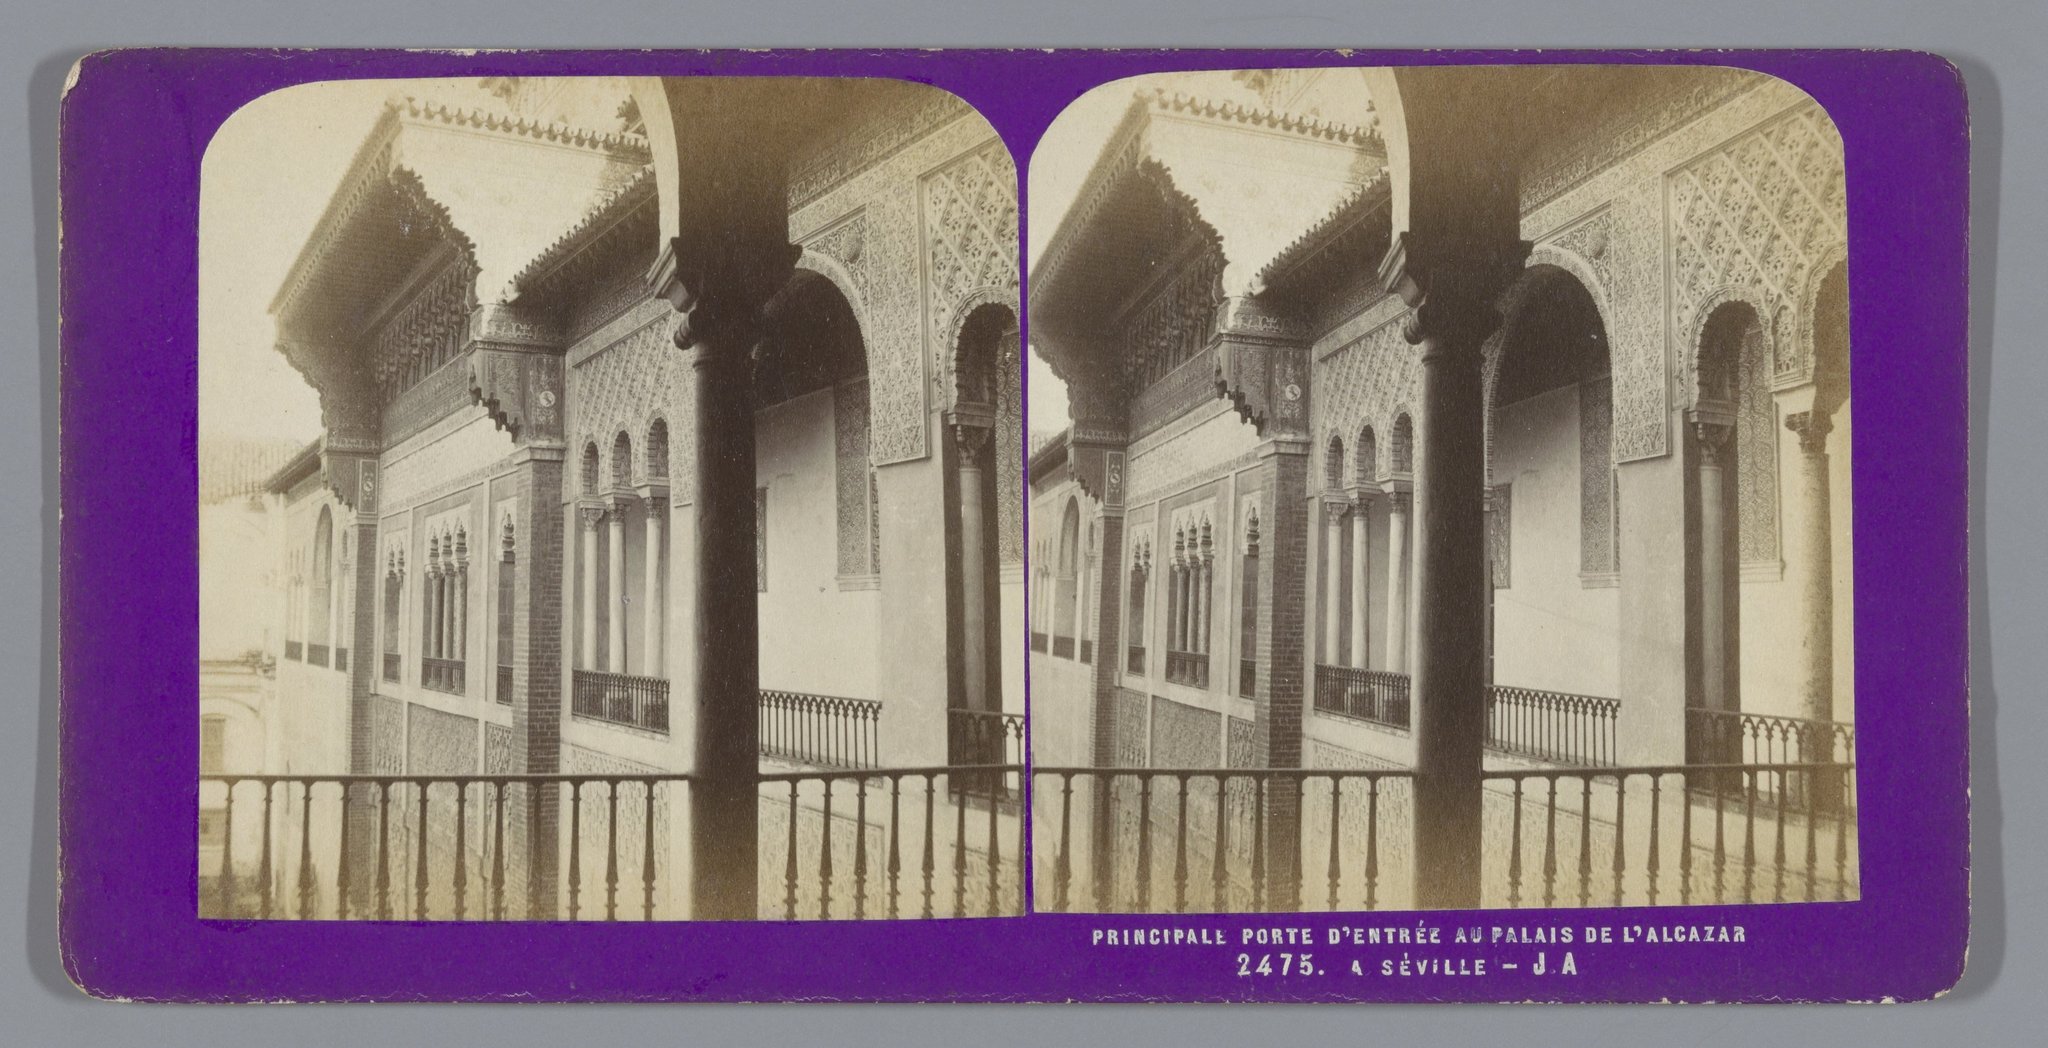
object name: stereograph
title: Principale Porte d'entree au Palais de l'Alcazar a Séville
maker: jean andrieu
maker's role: fotograaf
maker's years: 1816-1872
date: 1862-1876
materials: cardboard, photographic support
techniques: albumen print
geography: sevilla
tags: gate, entrance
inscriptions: number: ‘2475.’